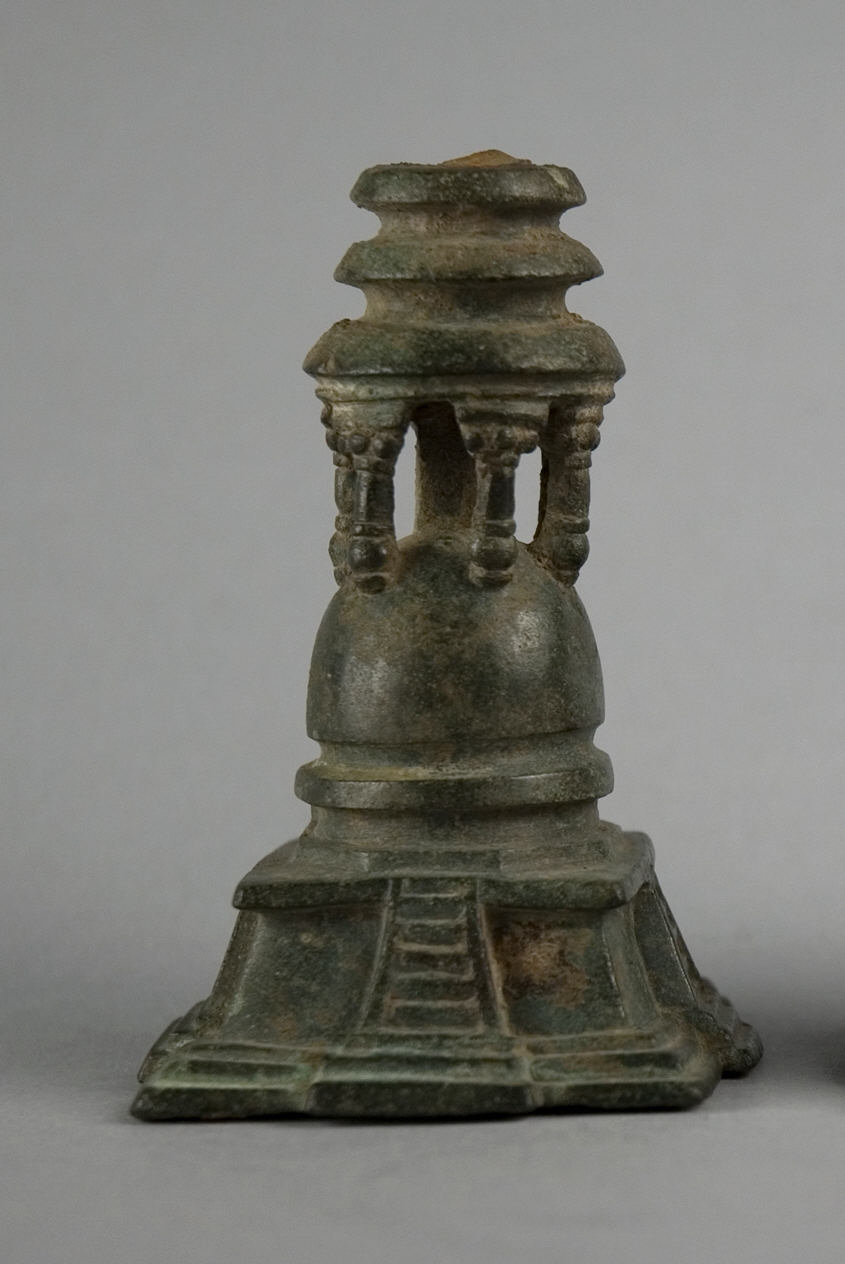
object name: stupa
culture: kashmiri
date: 601-900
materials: bronze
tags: kashmir